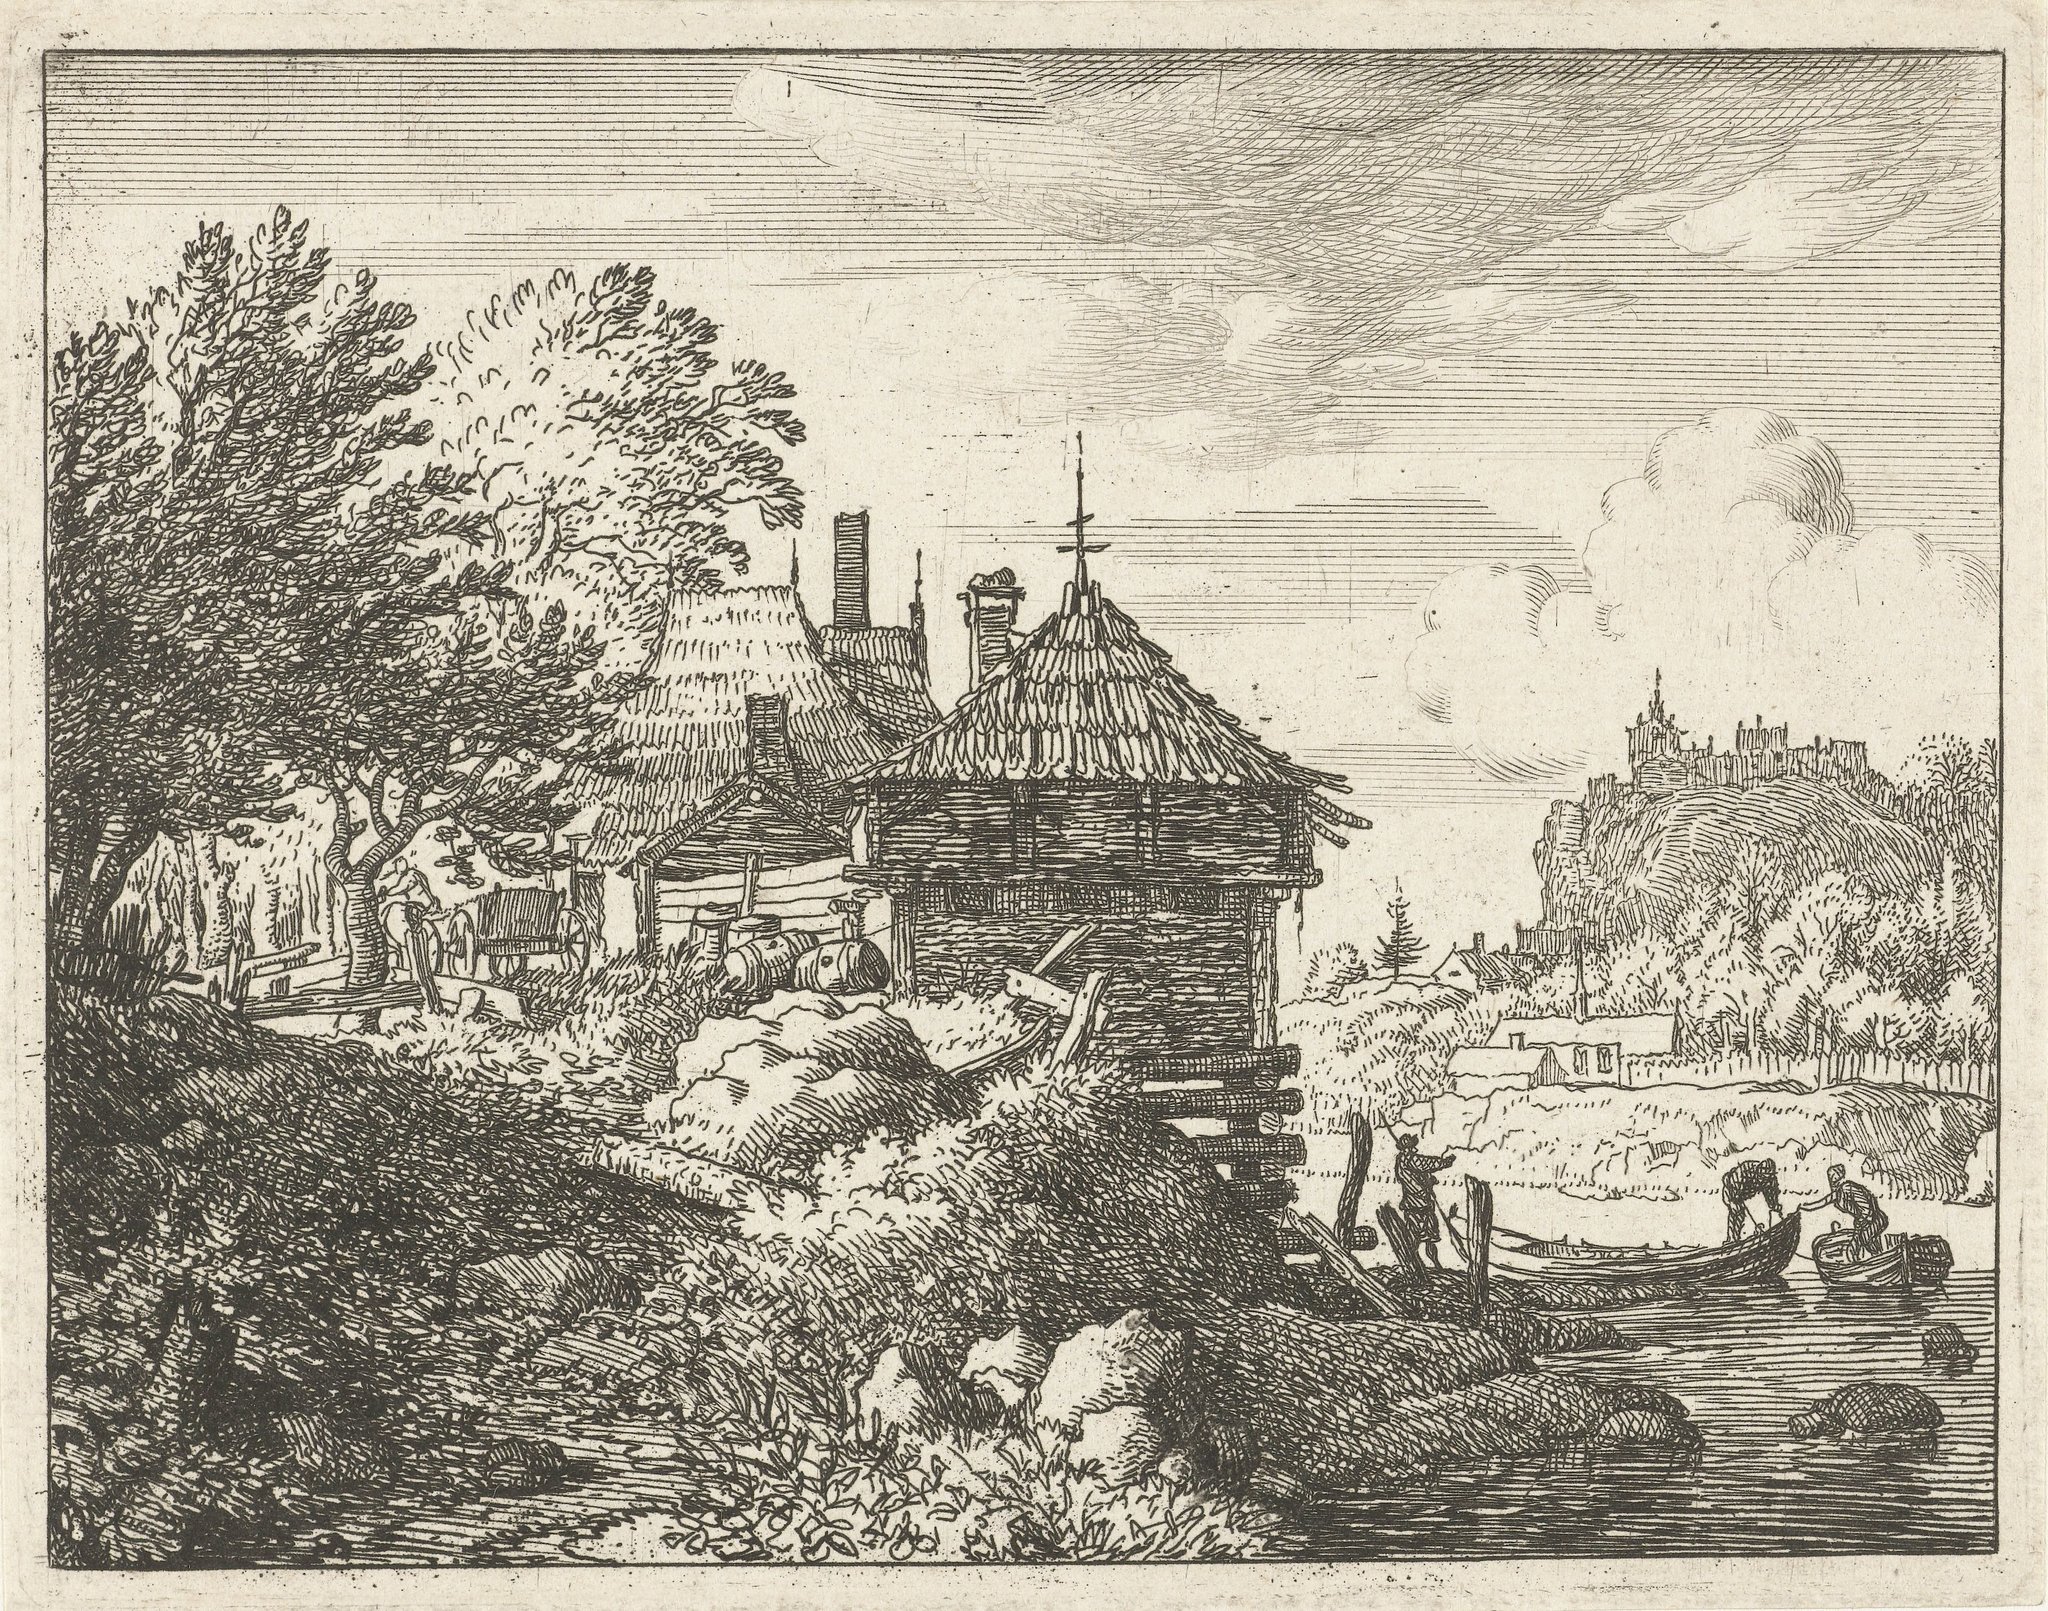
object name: print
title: Twee boten leggen aan bij een hut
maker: allaert van everdingen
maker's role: draughtsman, painter, print maker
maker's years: 1621-1675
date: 1631-1675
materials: paper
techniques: etching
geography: netherlands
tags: village (+ city(-scape) with figures, staffage)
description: Dorpsgezicht met paard en wagen. Op de oever van de rivier kijkt een man toe bij het aanleggen van twee roeiboten.